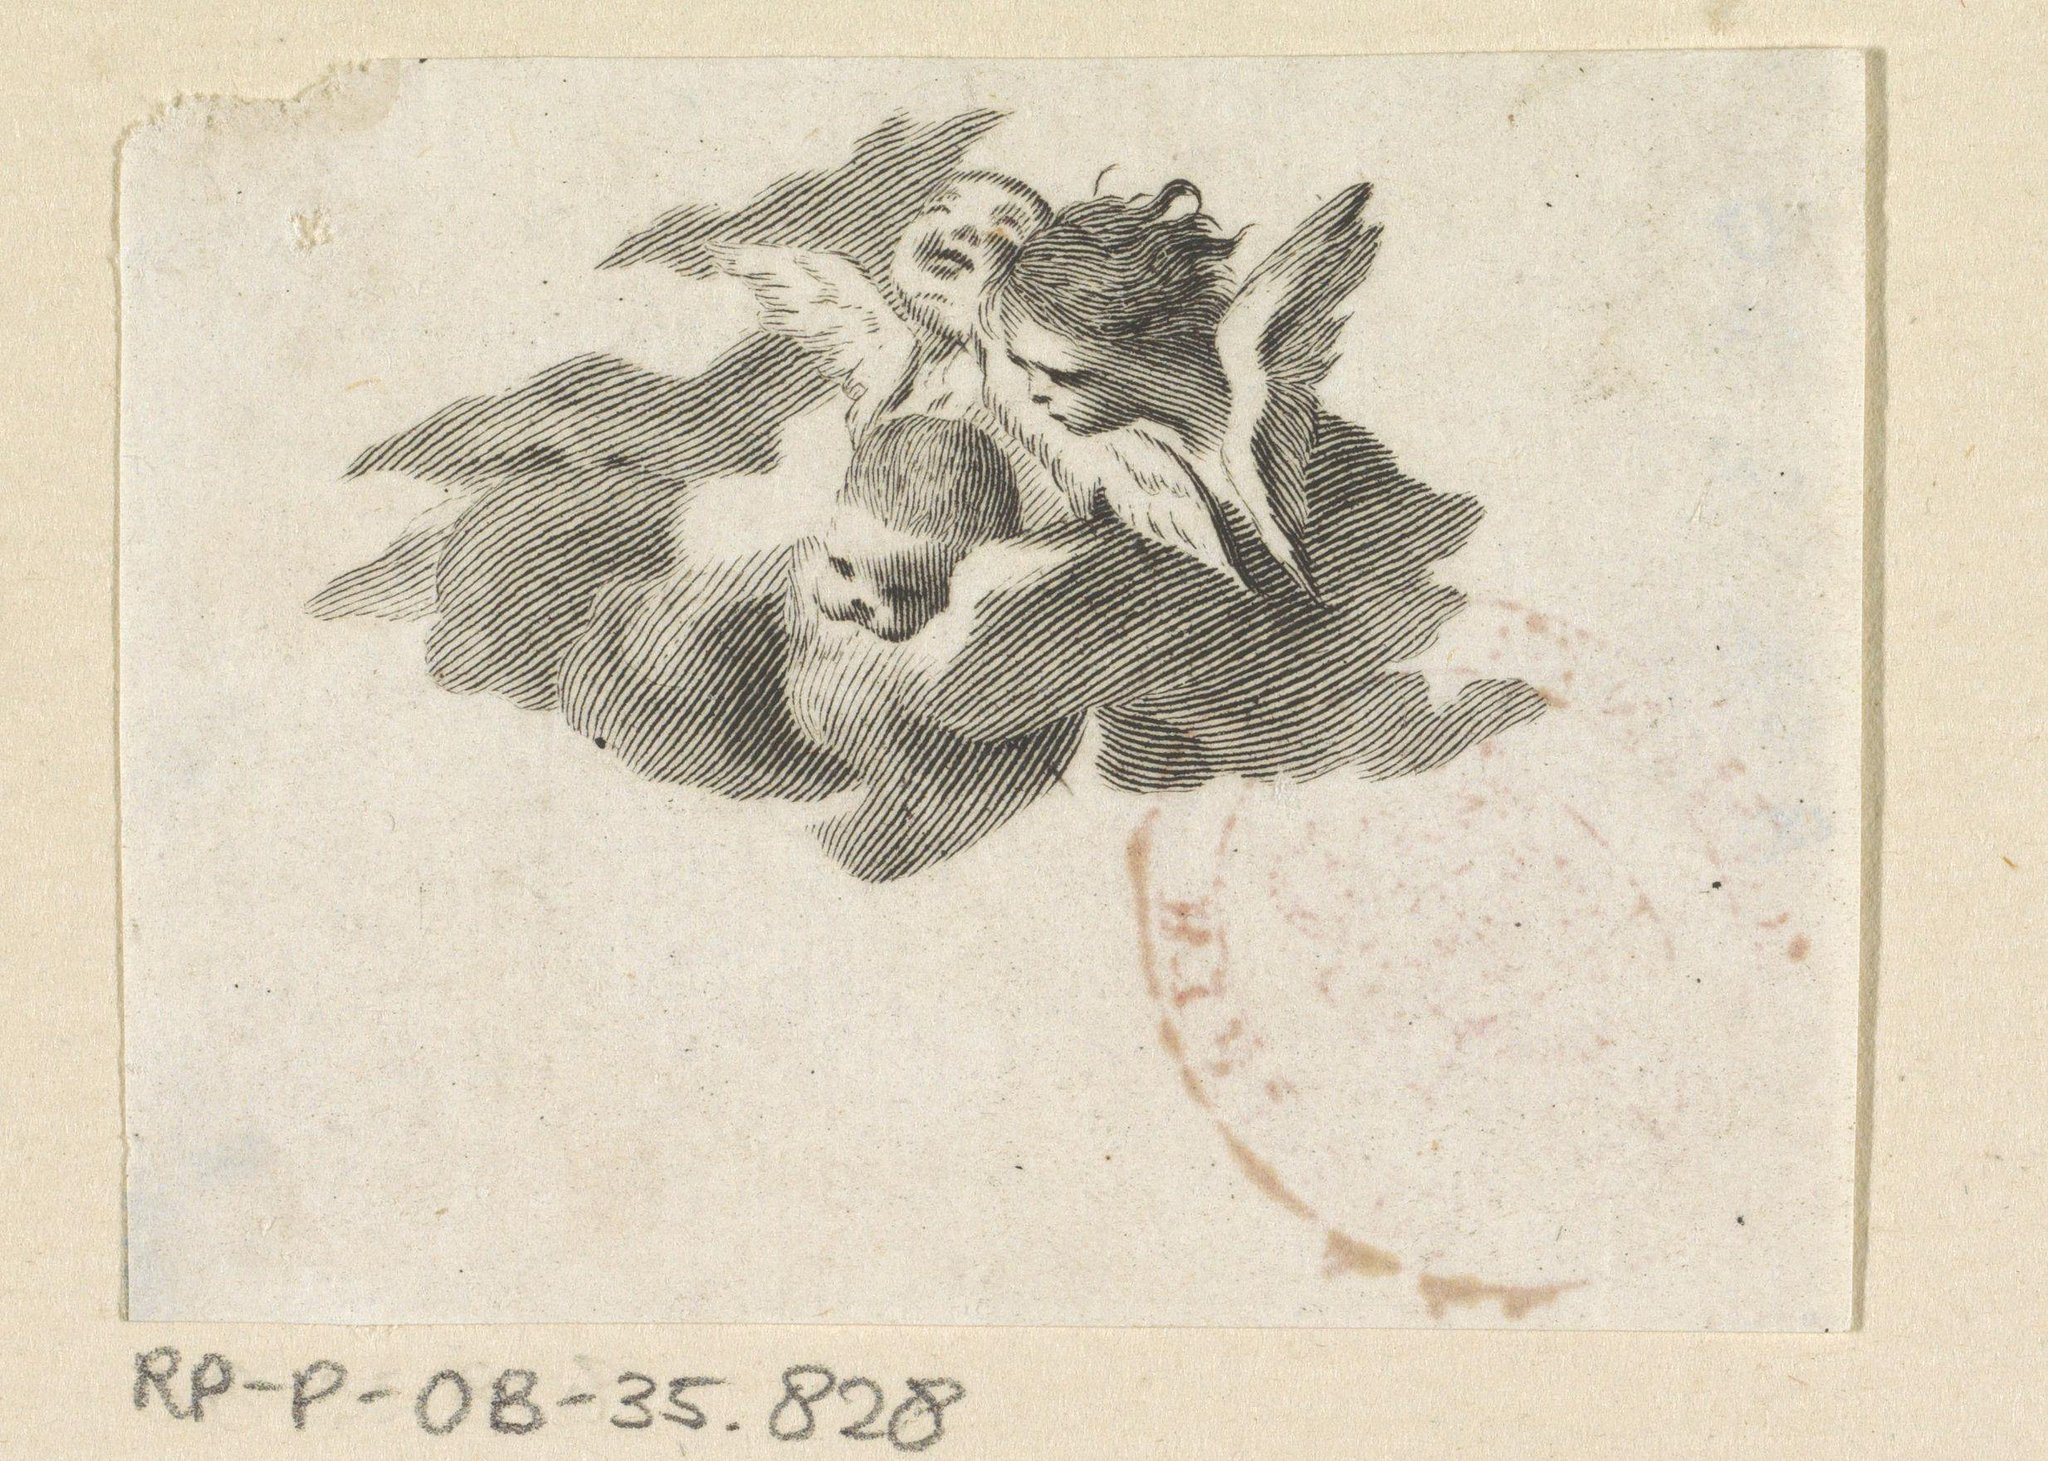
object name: print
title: Drie cherubijnen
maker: giovanni cattini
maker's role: print maker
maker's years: 1725-1800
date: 1735-1800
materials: paper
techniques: engraving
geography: italy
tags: cherubs, i.e. children's heads with wings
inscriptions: collector's mark: Lugt 240